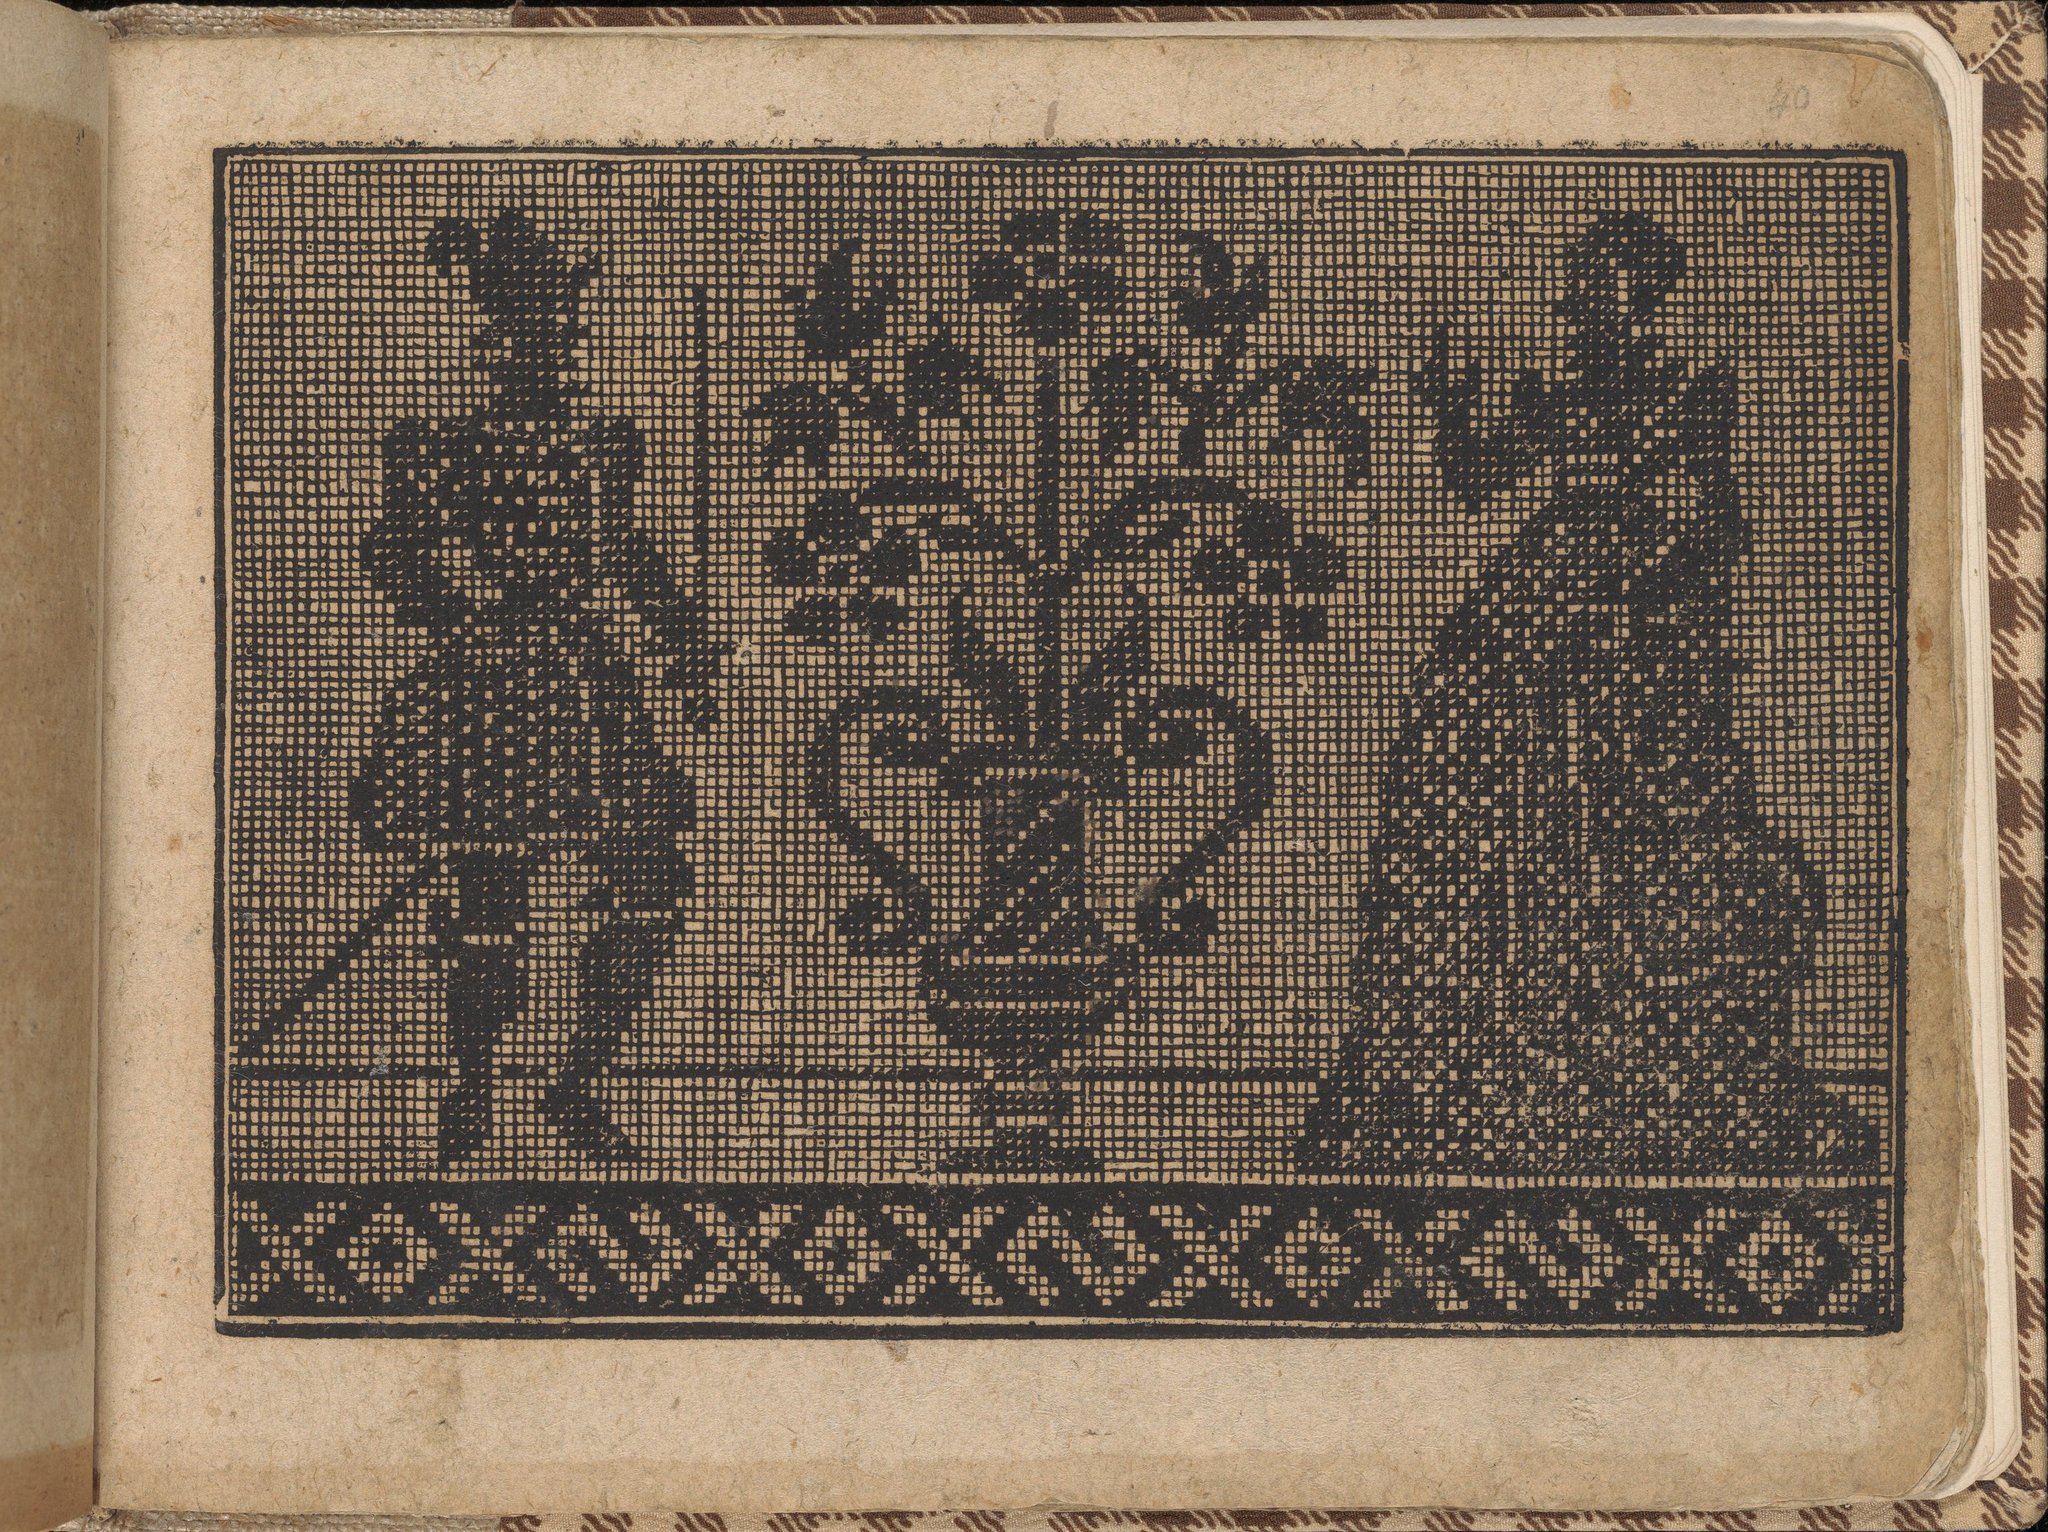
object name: book print ornament architecture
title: New Künstlichs Modelbuch (Page 40 recto)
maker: bernhard jobin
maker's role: publisher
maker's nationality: swiss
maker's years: 1535-1597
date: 1600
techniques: woodcut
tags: men,women